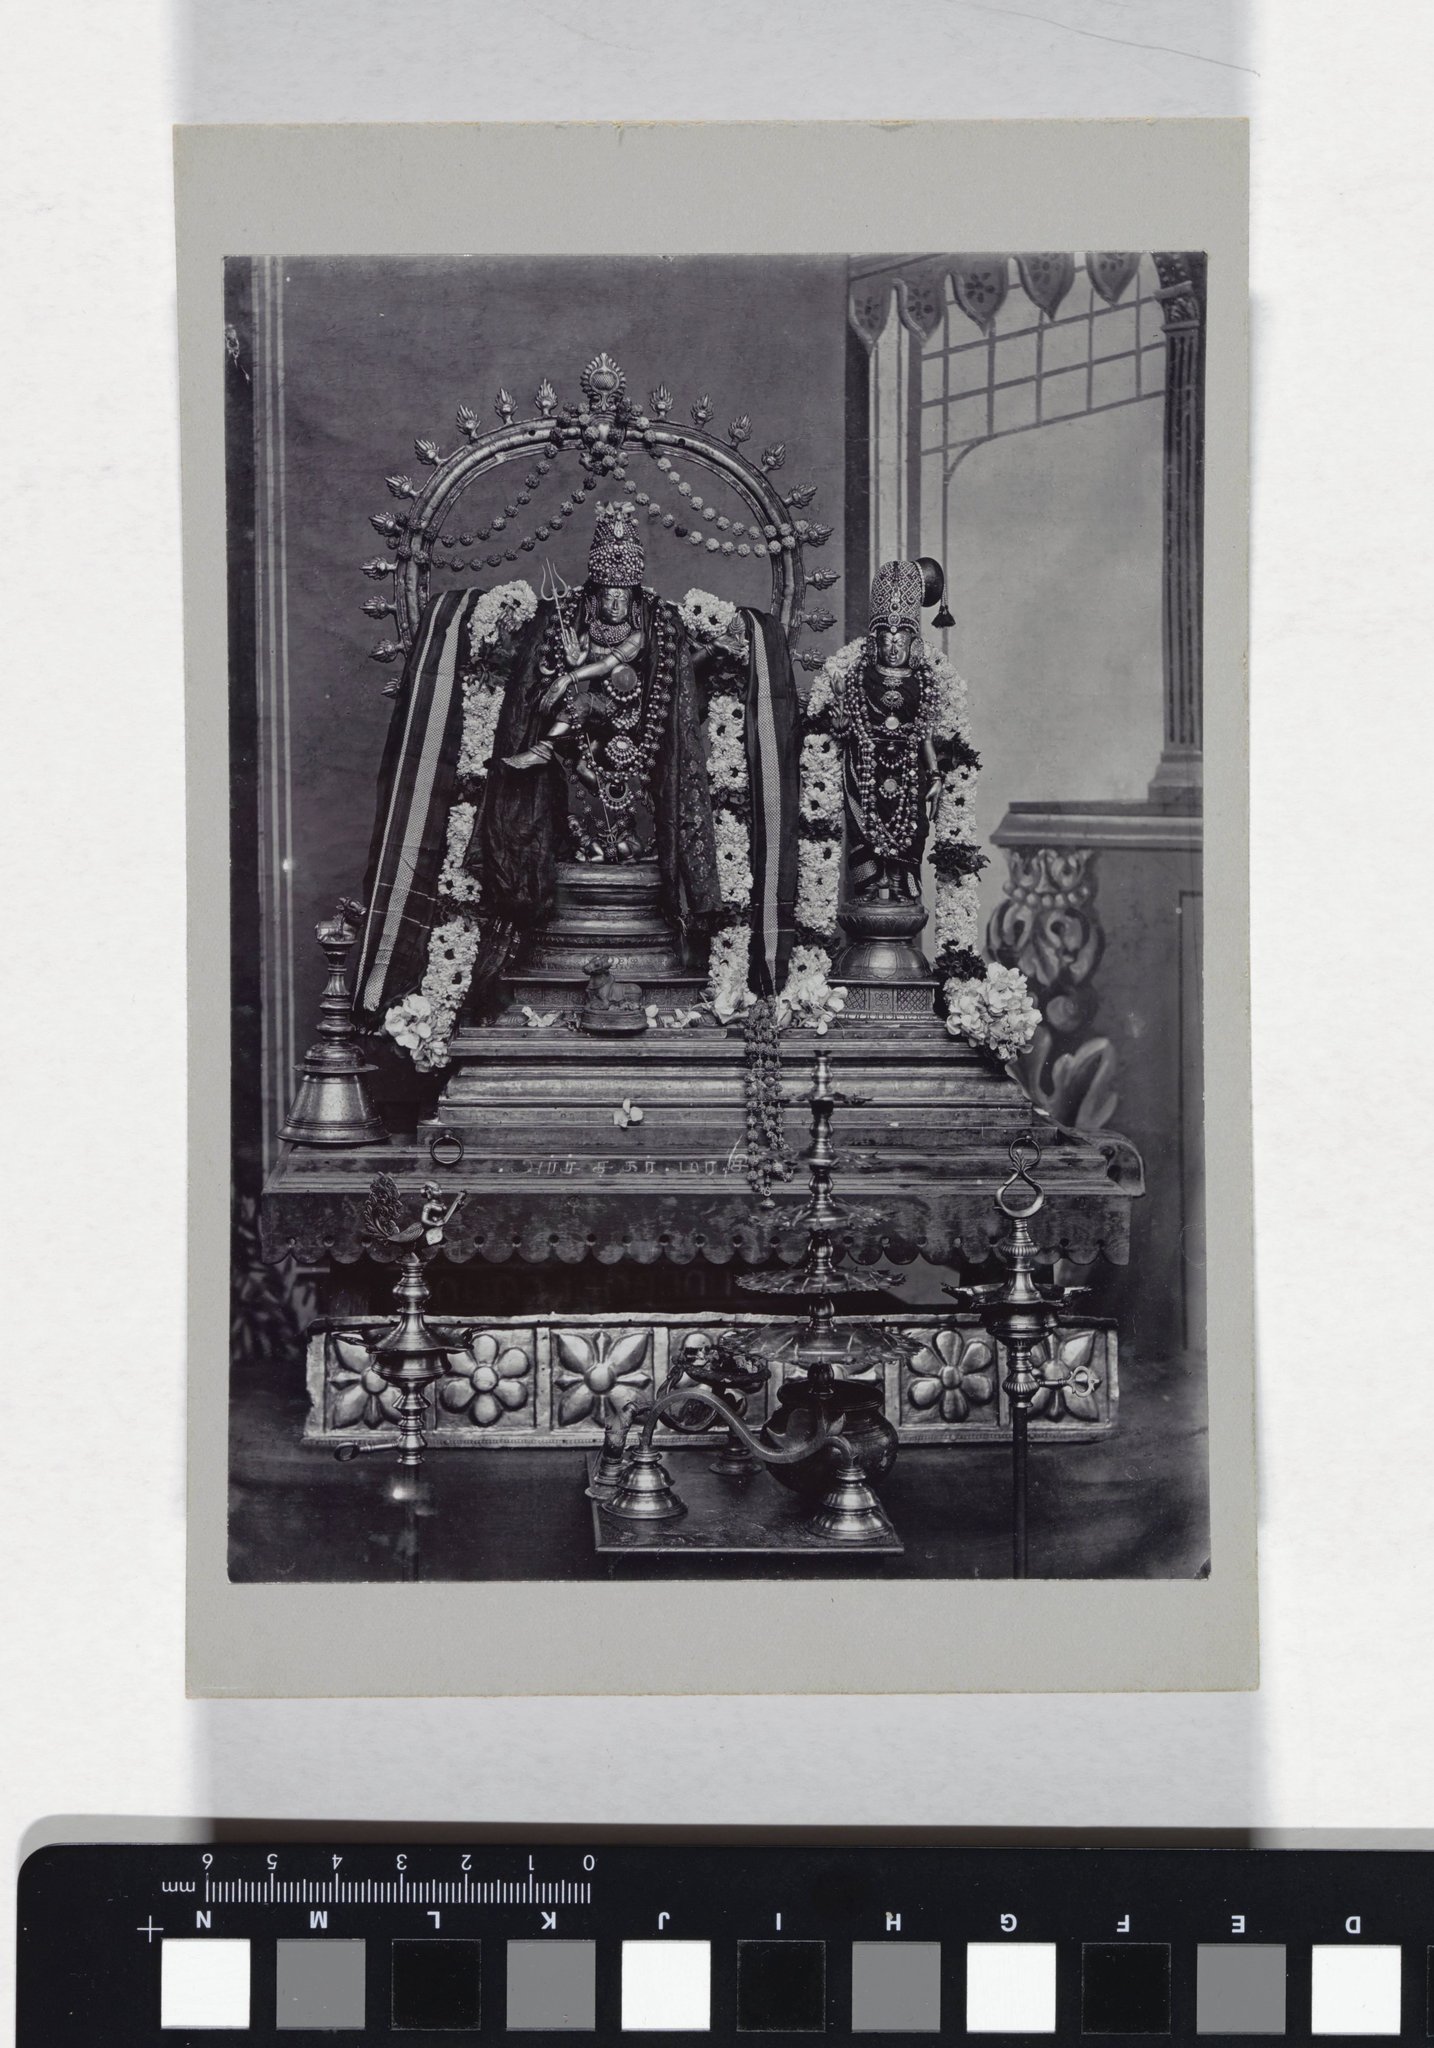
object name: photograph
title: Sculptures for worship of Shiva-Nataraja and Parvati inside the Meenakshi temple at Madurai, Tamil Nadu, India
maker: Anonymous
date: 1895-1915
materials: cardboard, paper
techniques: gelatin silver print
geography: madurai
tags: shiva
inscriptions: annotation: ‘77b. Tempel te Madura.’